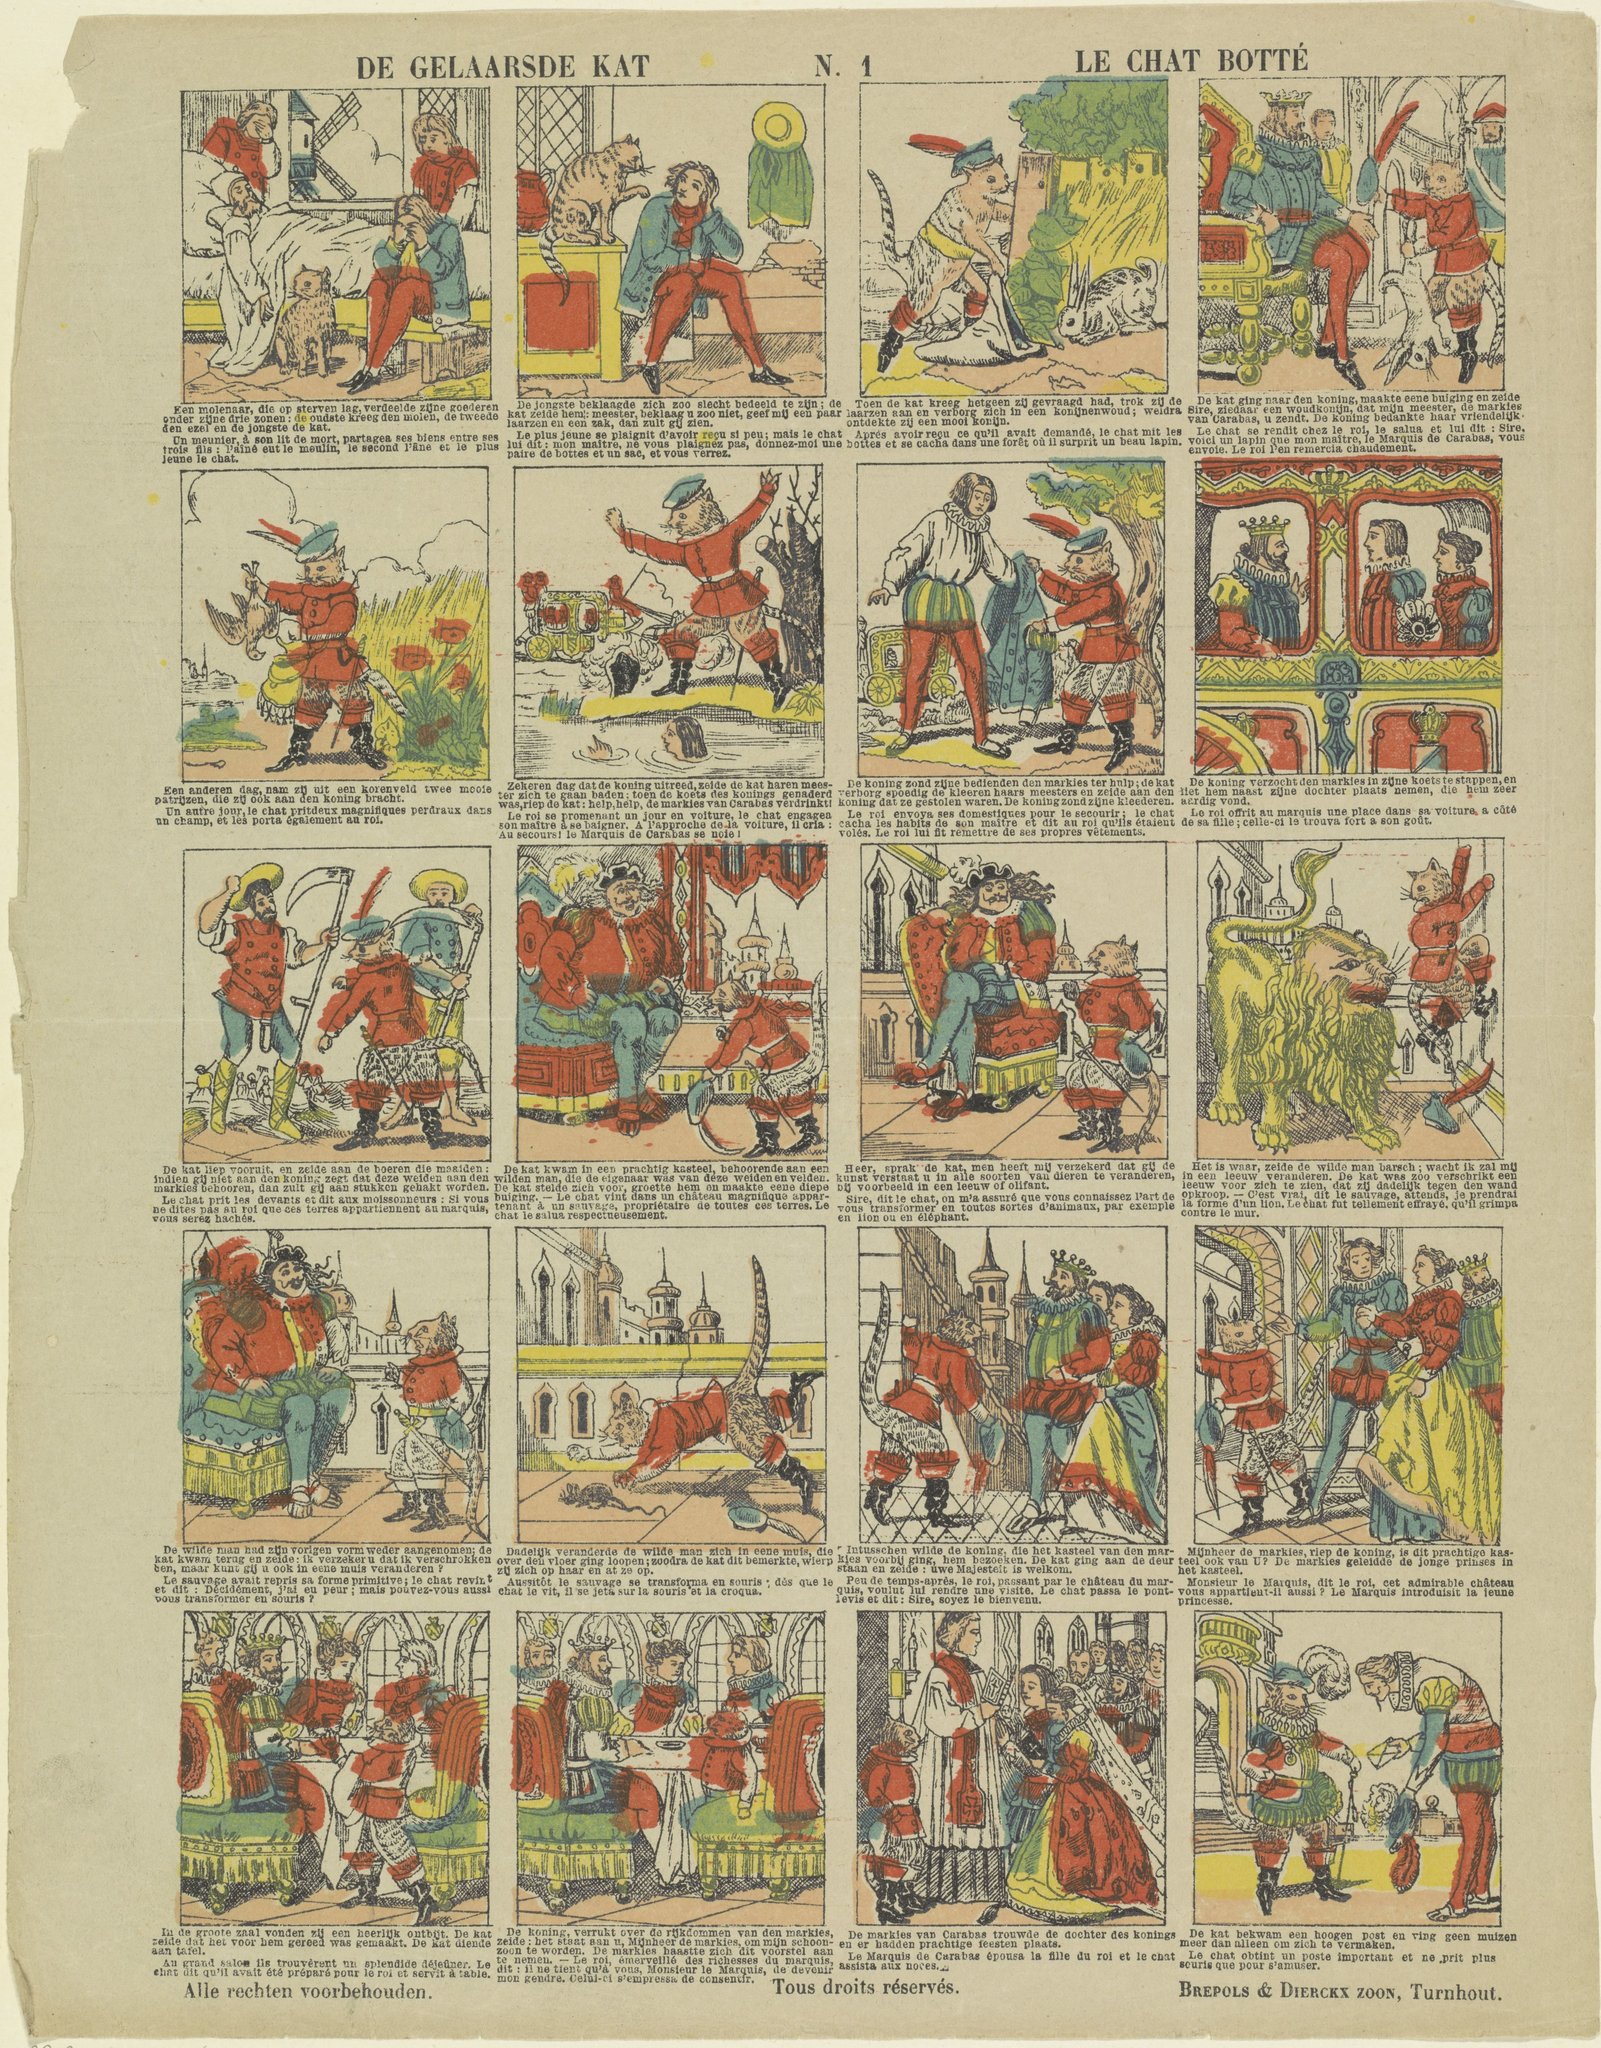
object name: print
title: De gelaarsde kat / Le chat botté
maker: Anonymous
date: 1833-1911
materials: paper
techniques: lithograph, letterpress printing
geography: turnhout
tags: tales and fairy tales, representations ~ goddesses, demi-goddesses, heroines, etc. (non-christian religions)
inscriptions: octrooivermelding, gedrukt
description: Blad met 16 voorstellingen uit het sprookje van de gelaarsde kat. Onder elke afbeelding een onderschrift in het Nederlands en in het Frans. Genummerd midden boven: N. 1.